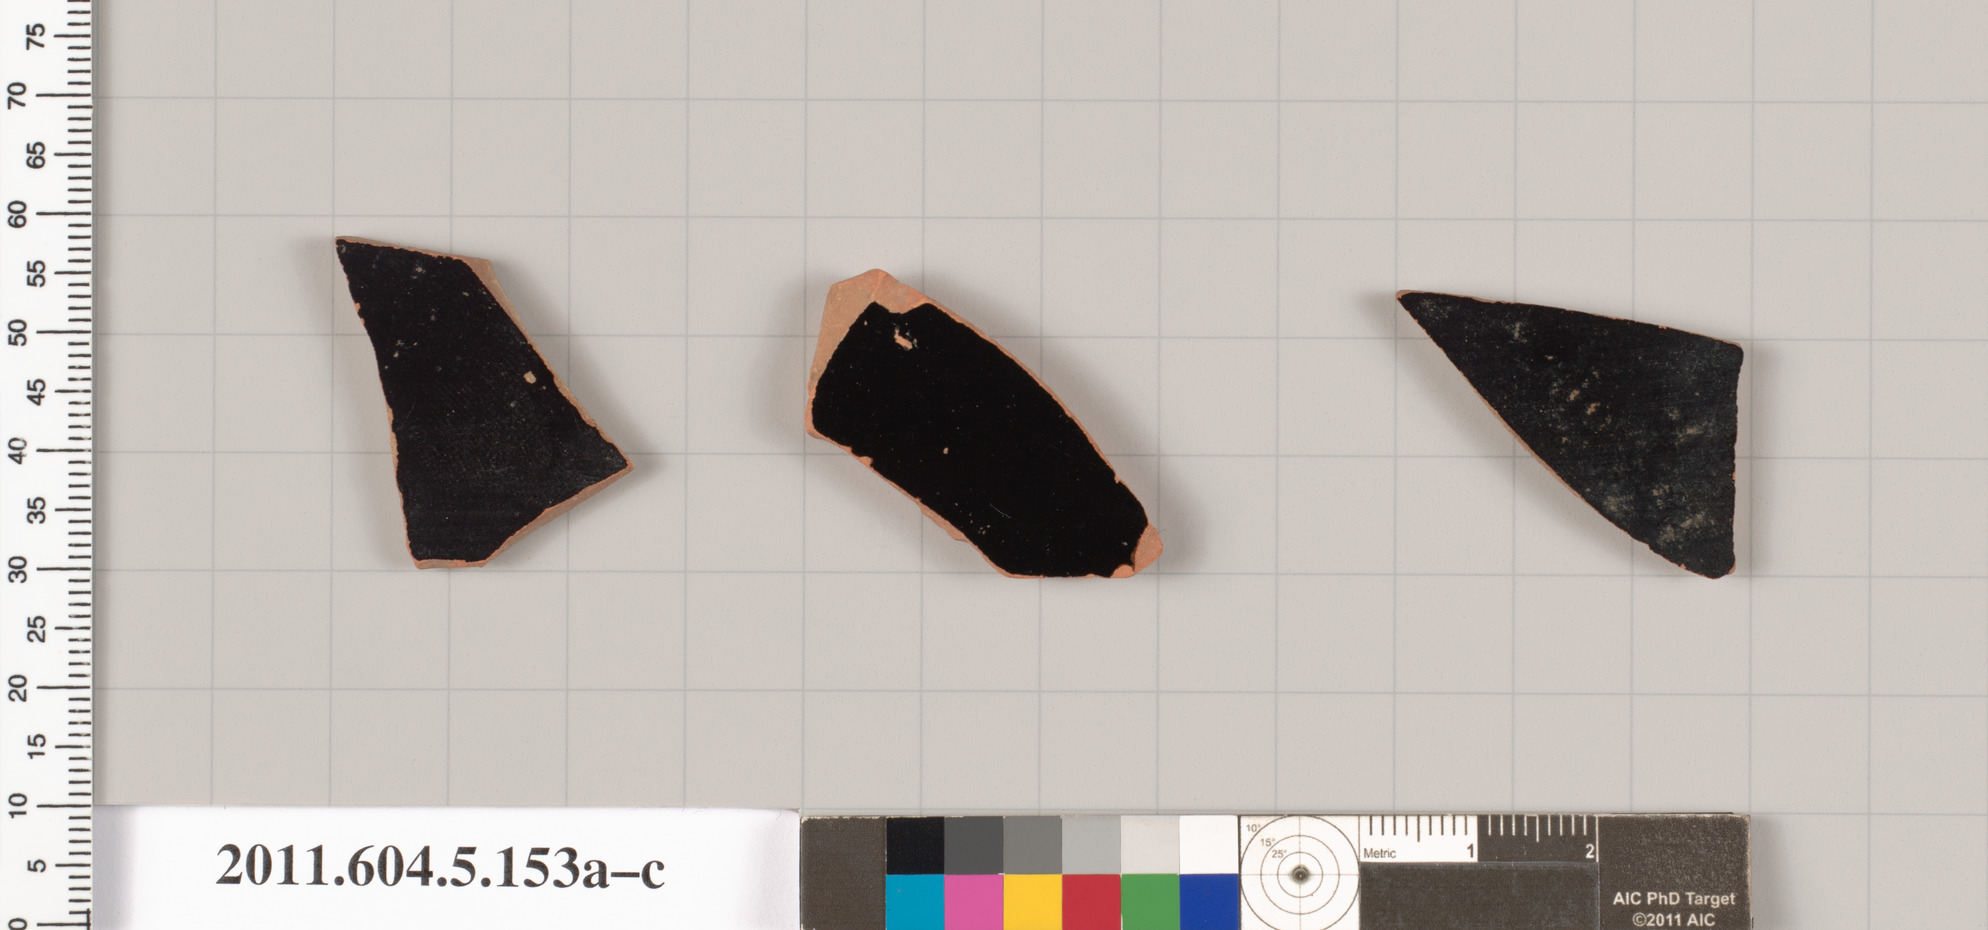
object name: kylix fragment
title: Terracotta fragments of kylikes (drinking cups)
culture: greek, attic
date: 600-401 BCE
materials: terracotta